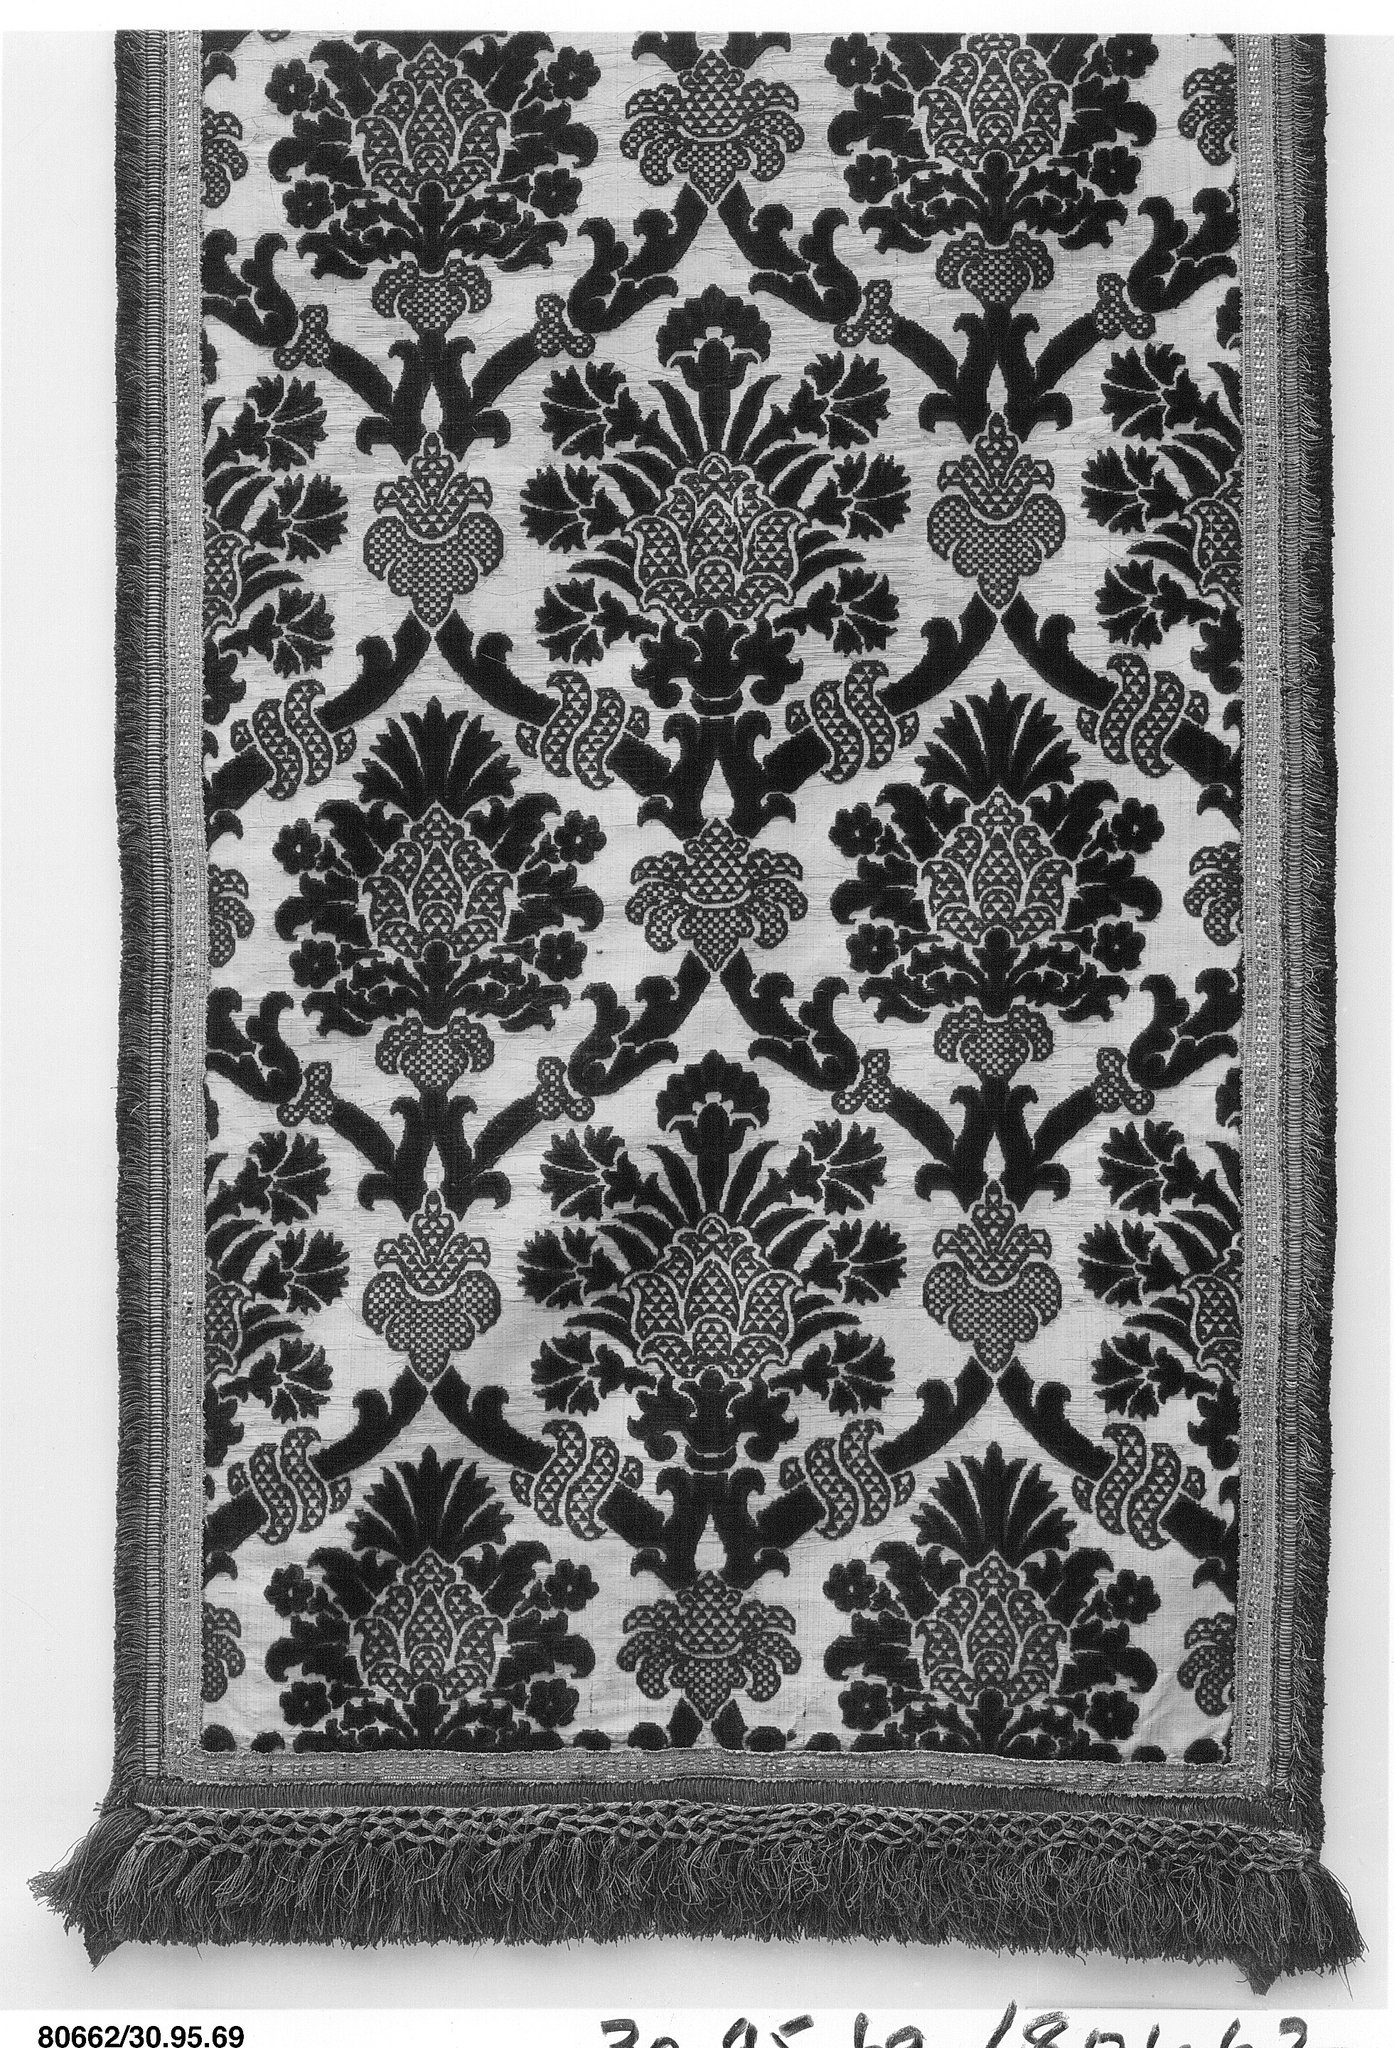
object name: panel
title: Panel of velvet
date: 1551-1600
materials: metal thread, silk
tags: flowers,leaves